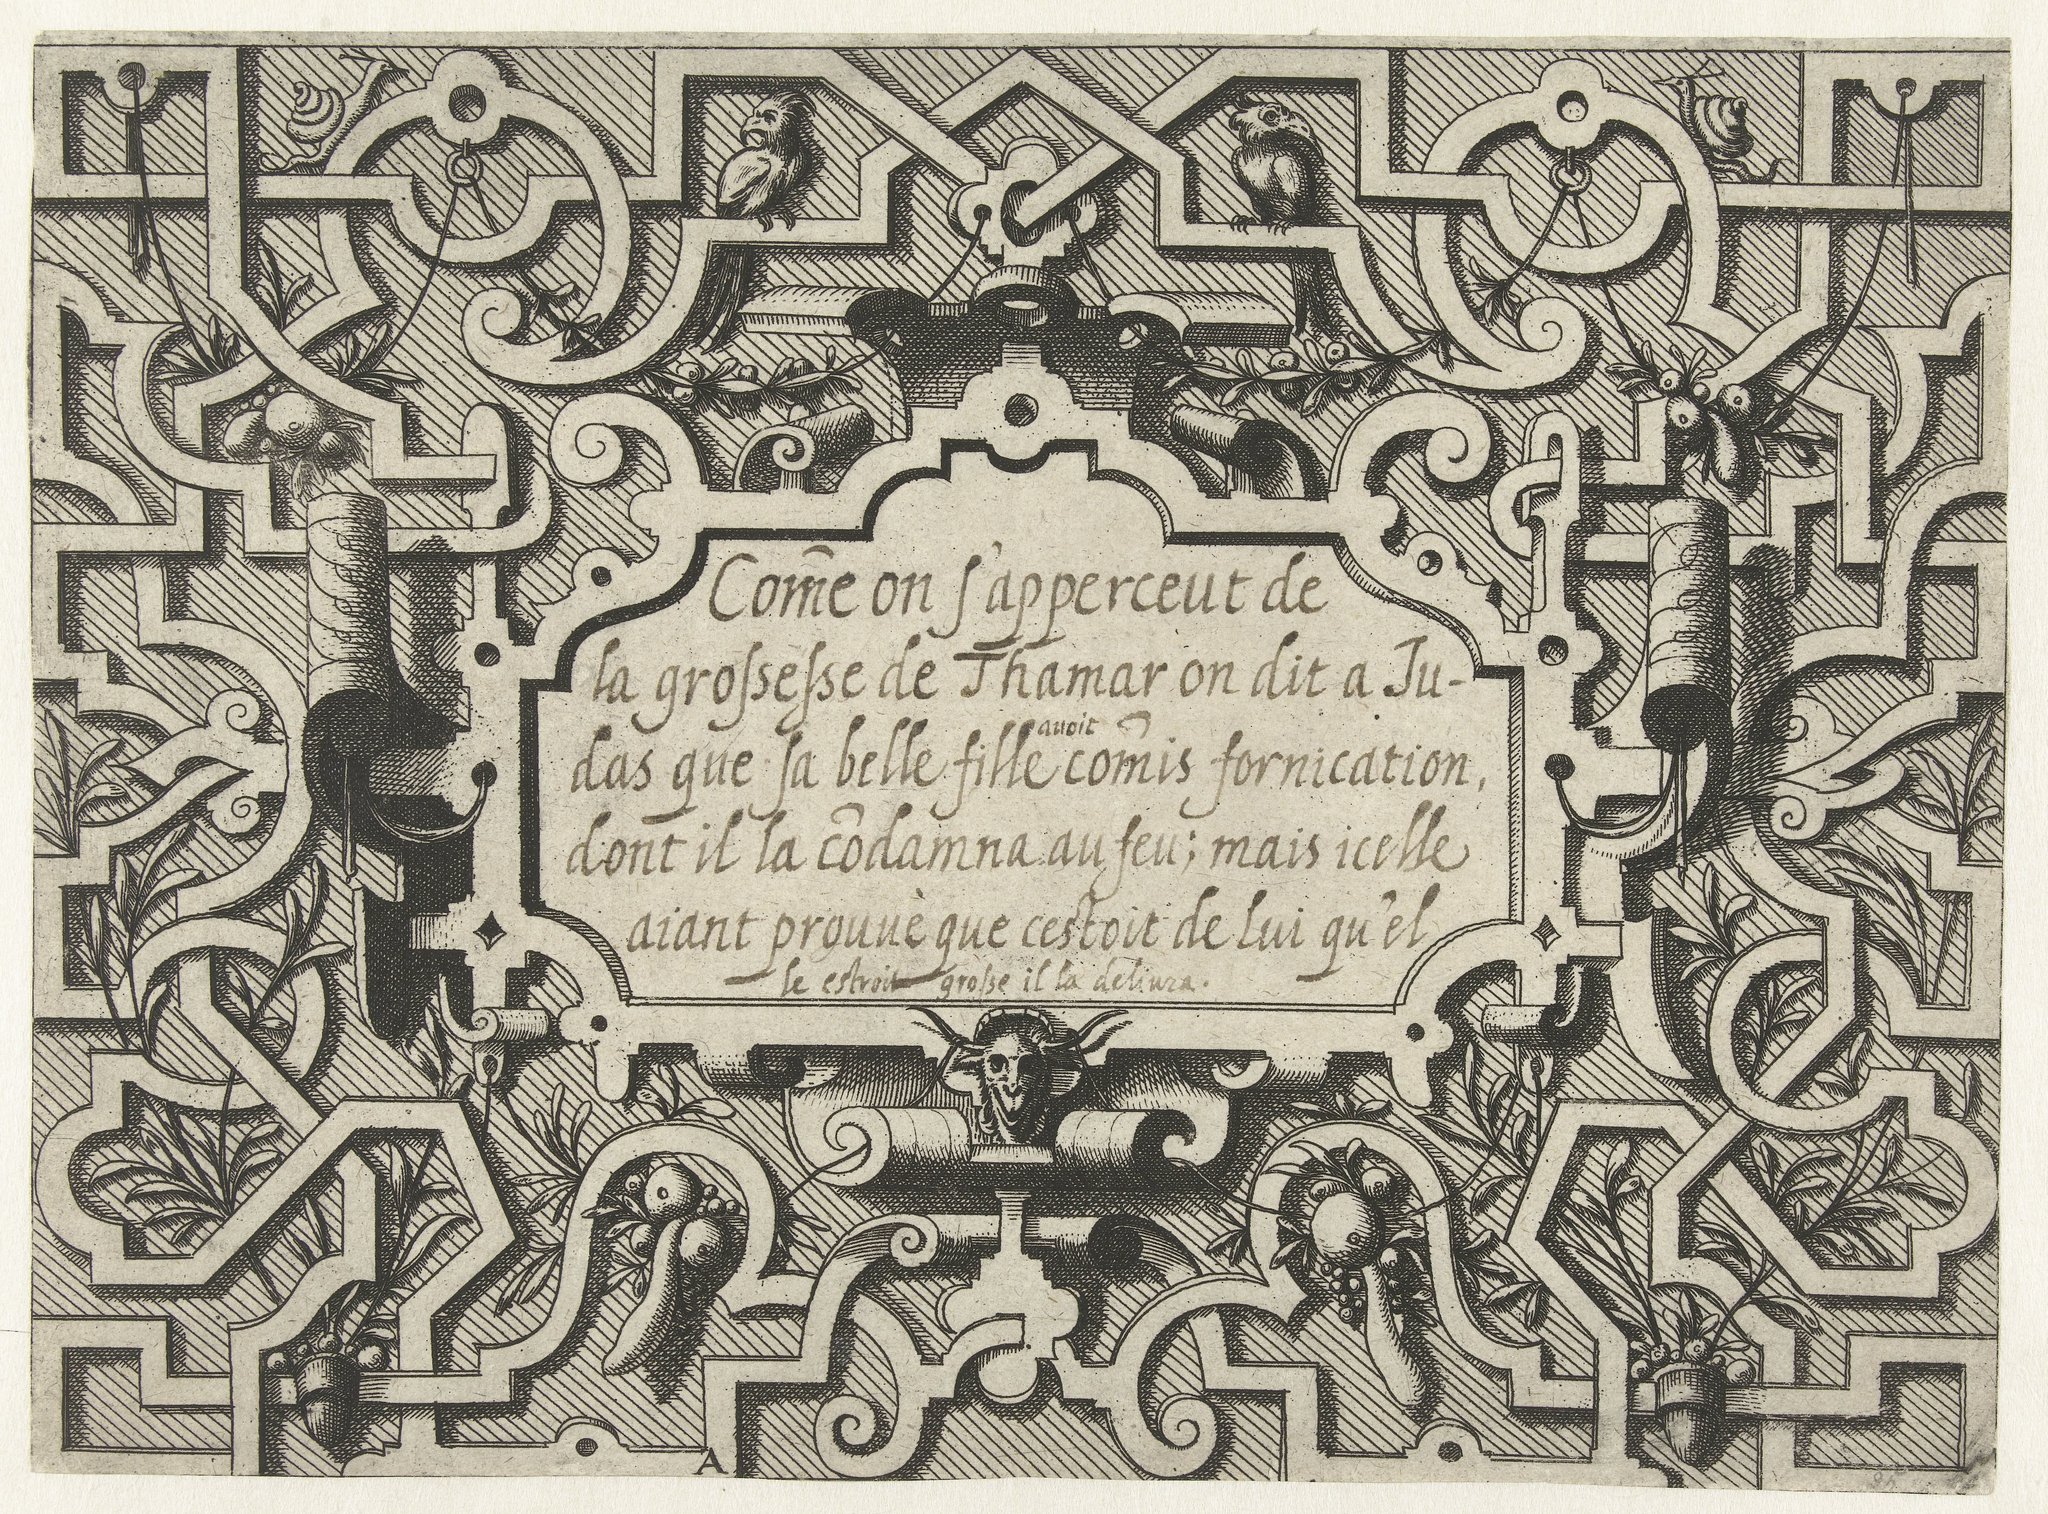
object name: ornament print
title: Cartouche omgeven door moresken, bovenaan twee vogels en twee slakken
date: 1555-1560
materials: paper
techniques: etching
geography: netherlands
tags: ornament ~ moresque, ornament ~ cartouche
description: In de cartouche is met pen een tekst geschreven (Come on s'apperceut de/ la grossesse de Thamar...). Blad A uit serie van 16 bladen, geletterd A-Q. Gearceerde of gestippelde achtergrond.